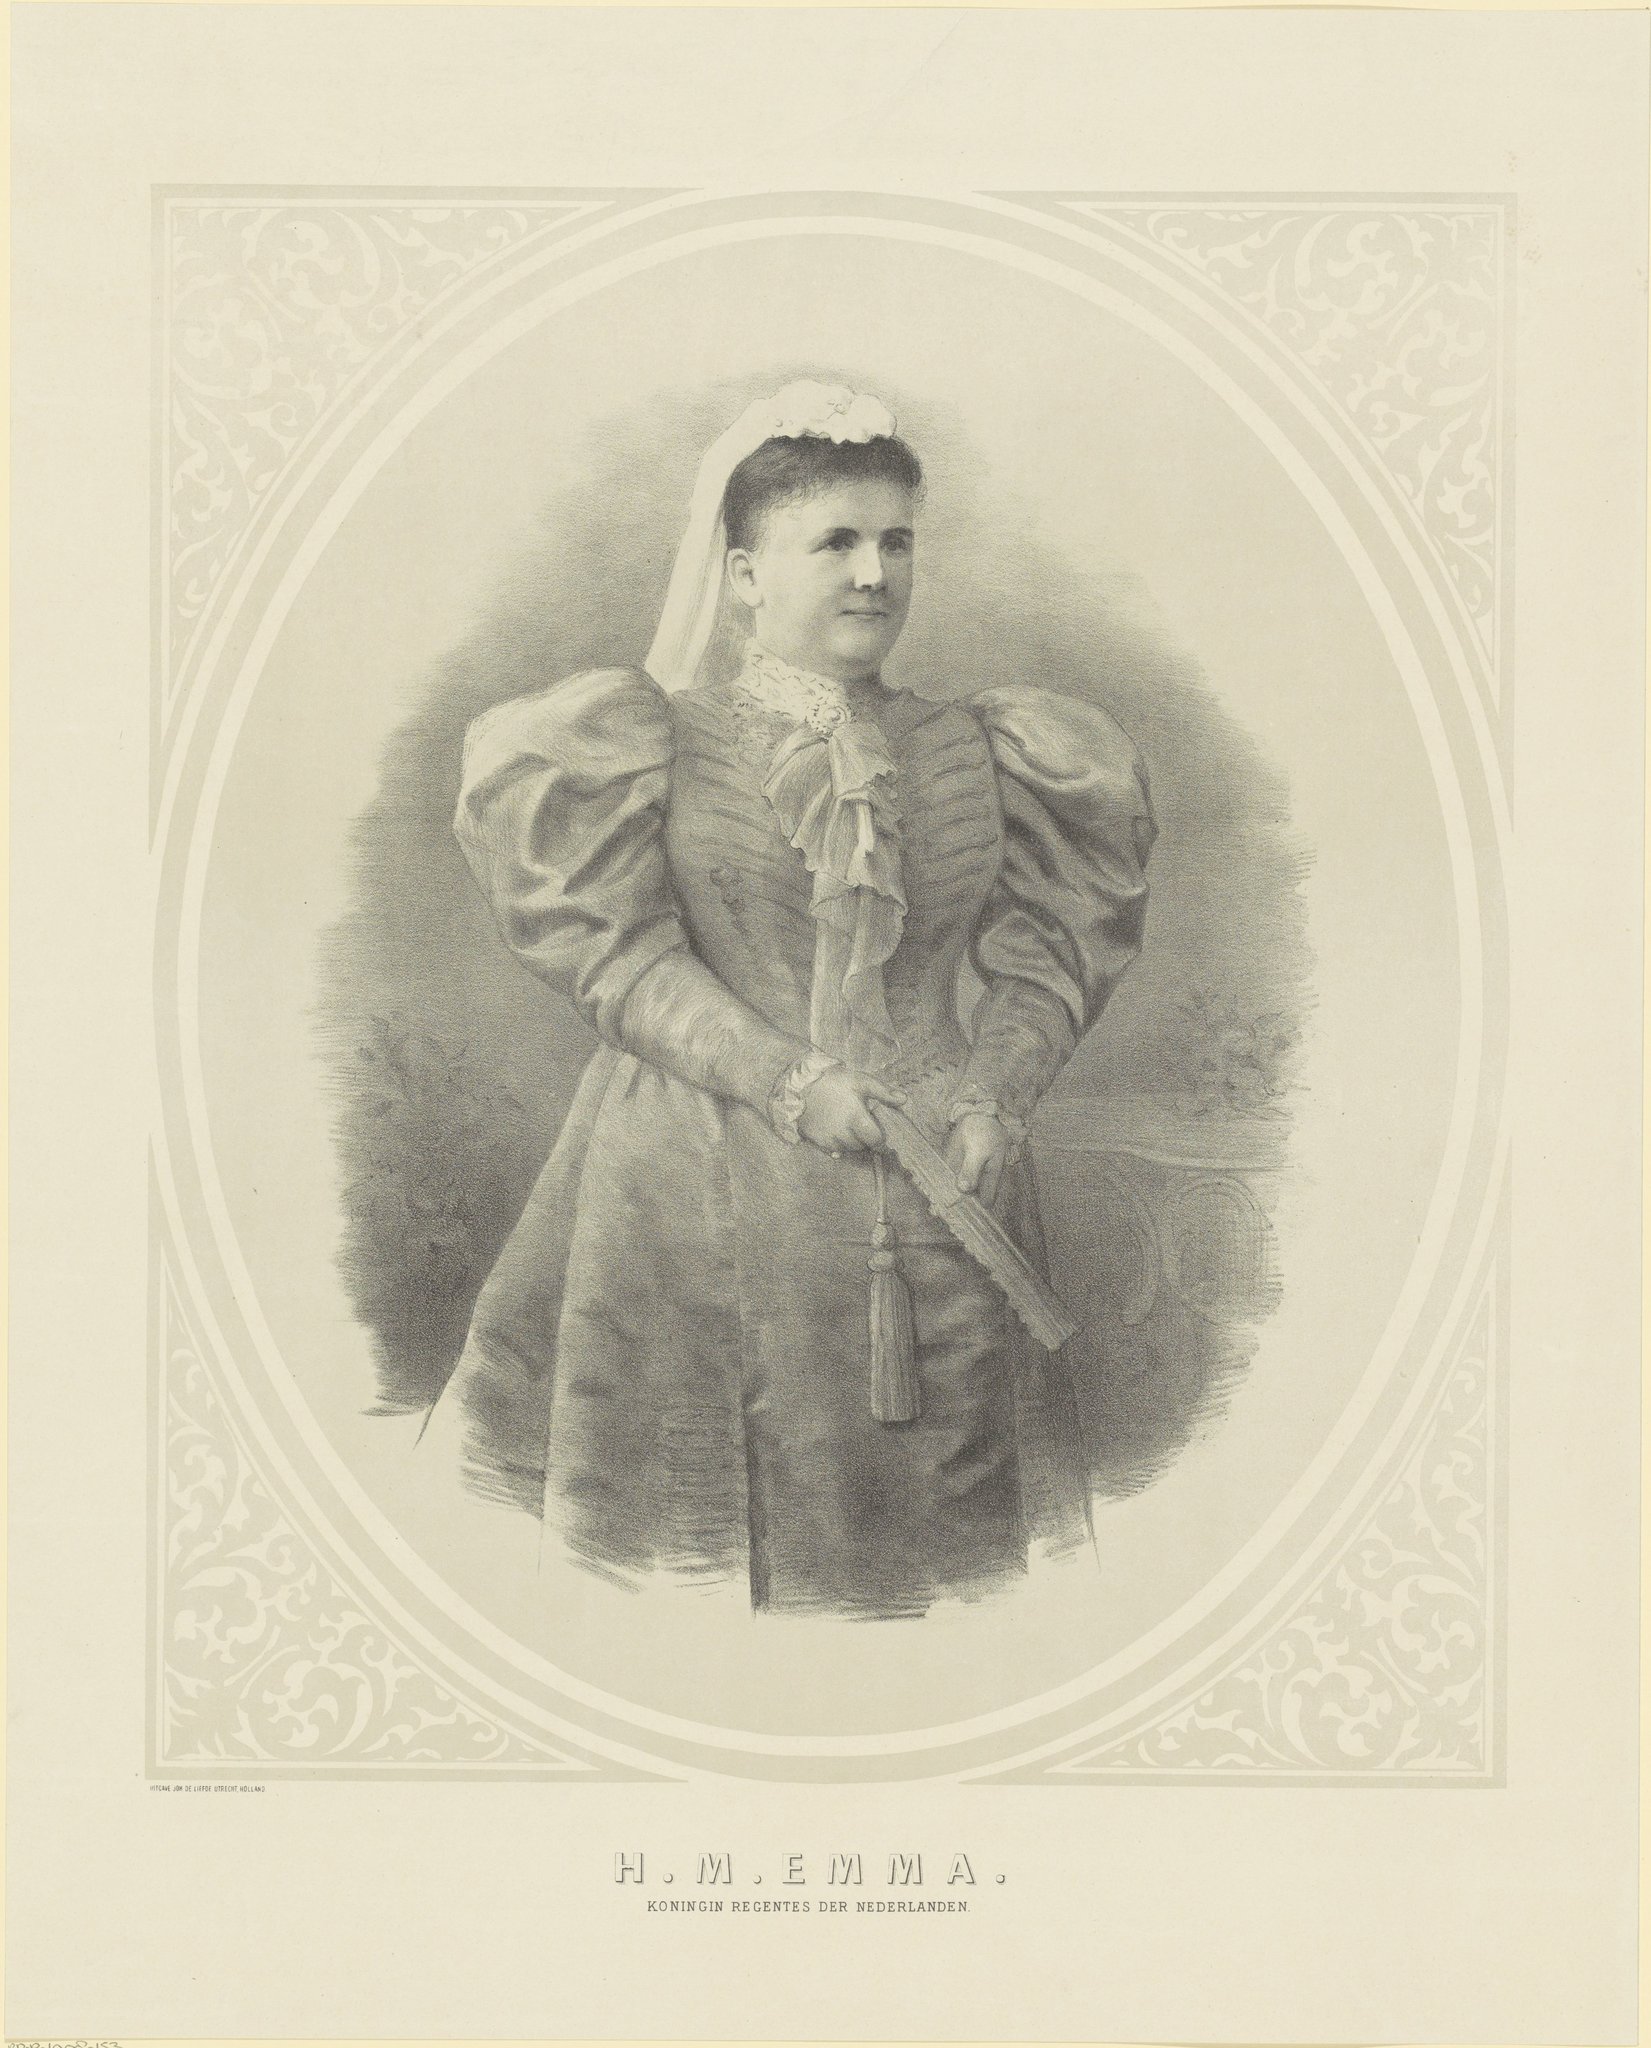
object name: print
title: Portret van Emma, koningin-regentes der Nederlanden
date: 1890-1908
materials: paper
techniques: tone lithography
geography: netherlands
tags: the hague, emma (queen consort of the netherlands)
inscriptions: collector's mark: Lugt 2228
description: De hier vermelde titel verwijst naar de hoogst verkregen titel van de geportretteerde, niet per se naar de titel die de geportretteerde op deze voorstelling draagt.